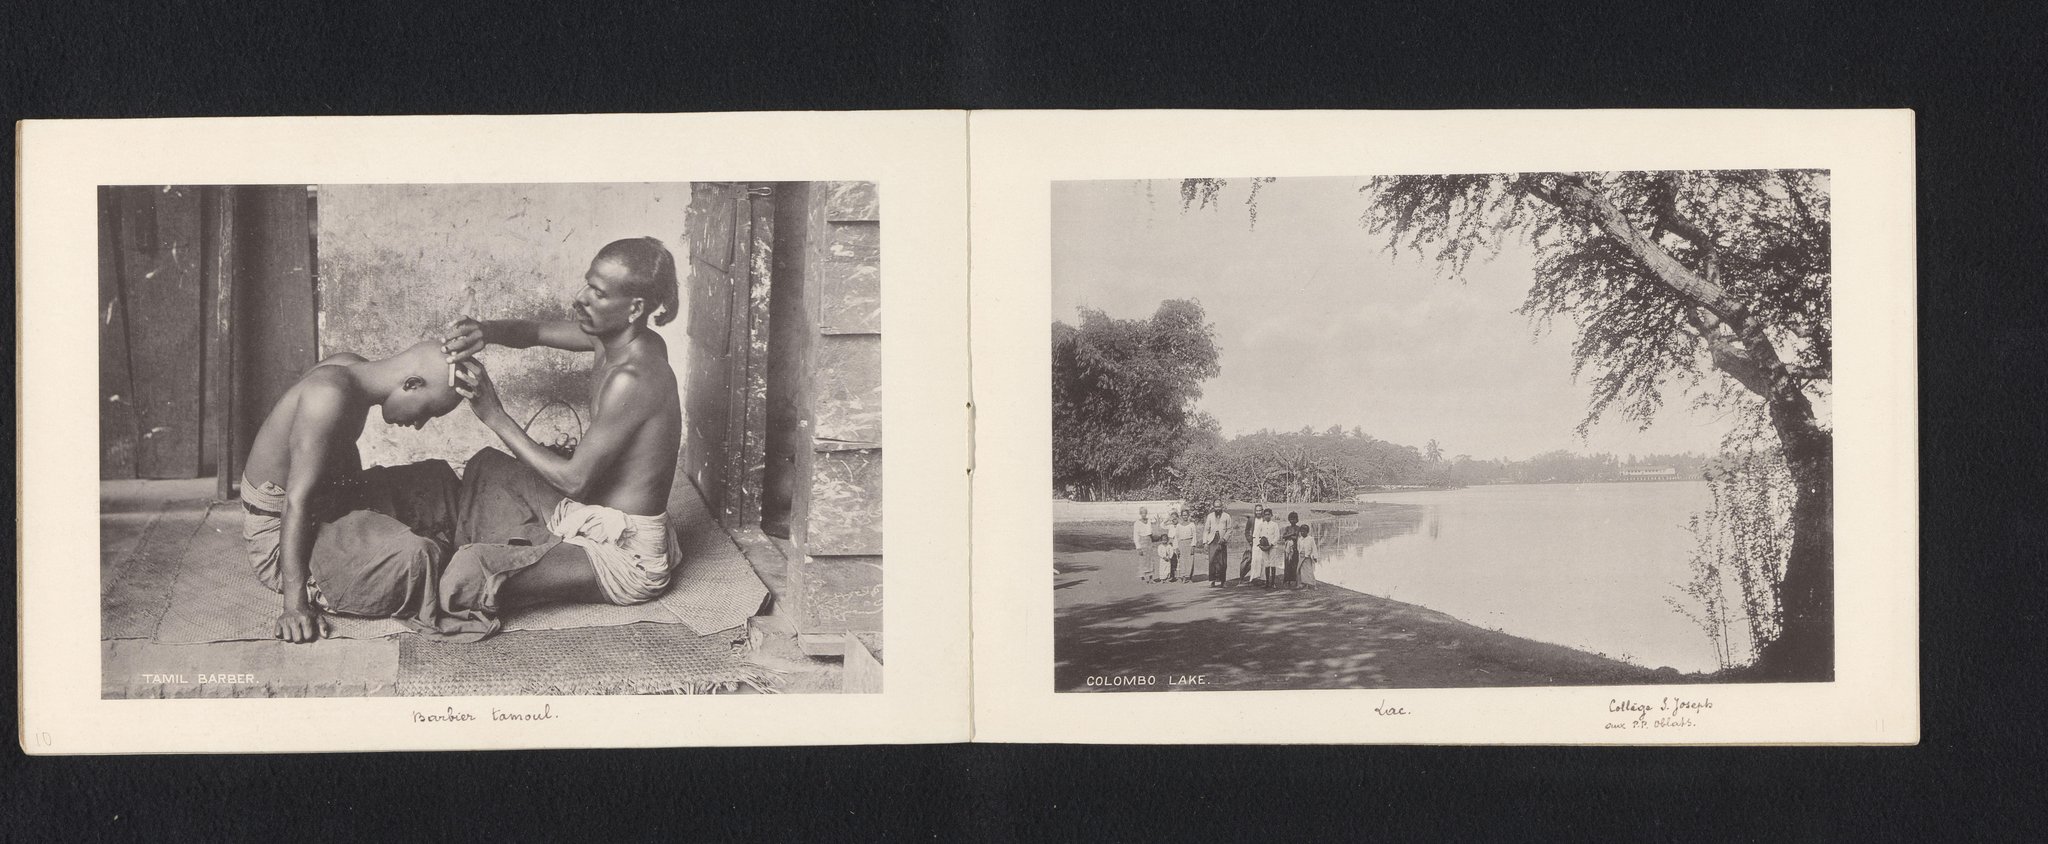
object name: photomechanical print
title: Gezicht op een groep onbekende personen aan een meer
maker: henry william cave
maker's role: fotograaf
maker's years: 1854-1913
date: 1890-1910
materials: paper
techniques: photograph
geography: colombo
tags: lake, anonymous historical persons portrayed in a group, in a group-portrait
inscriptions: inscription: ‘Lac. Collége S. Joseph/ aux P.P. Abbots.’